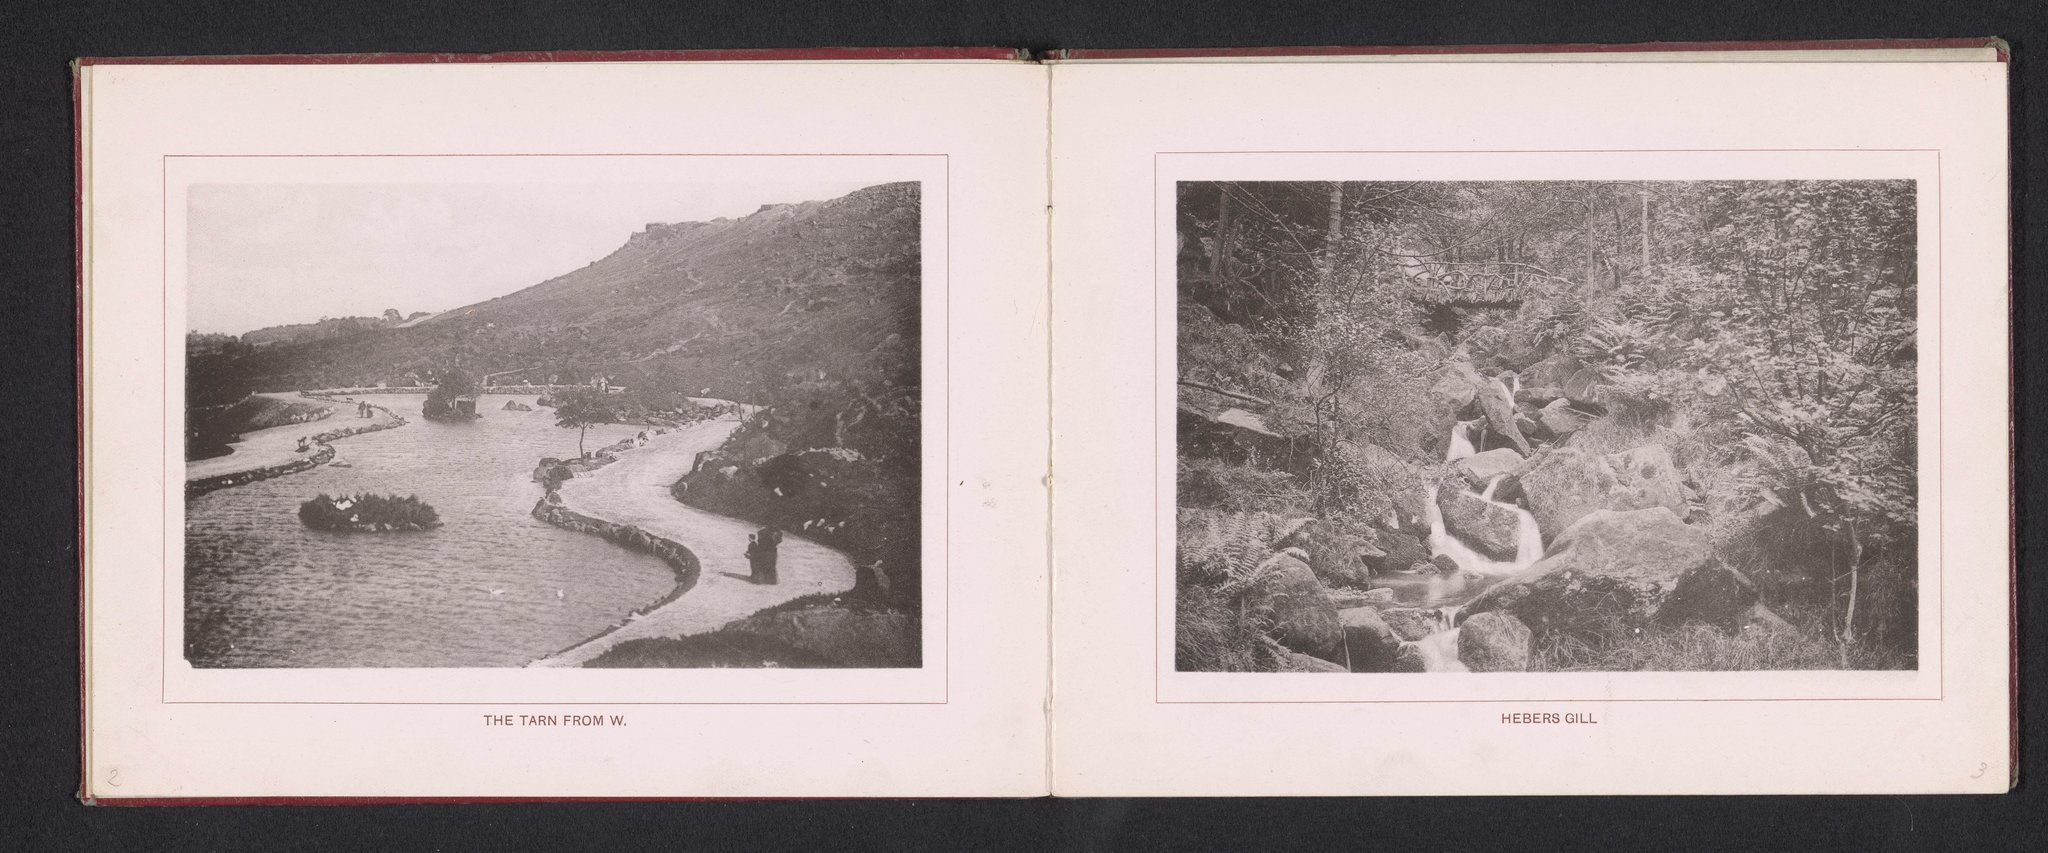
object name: page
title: The Tarn from W.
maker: Anonymous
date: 1890-1900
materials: paper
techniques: photograph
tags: lake, mountains